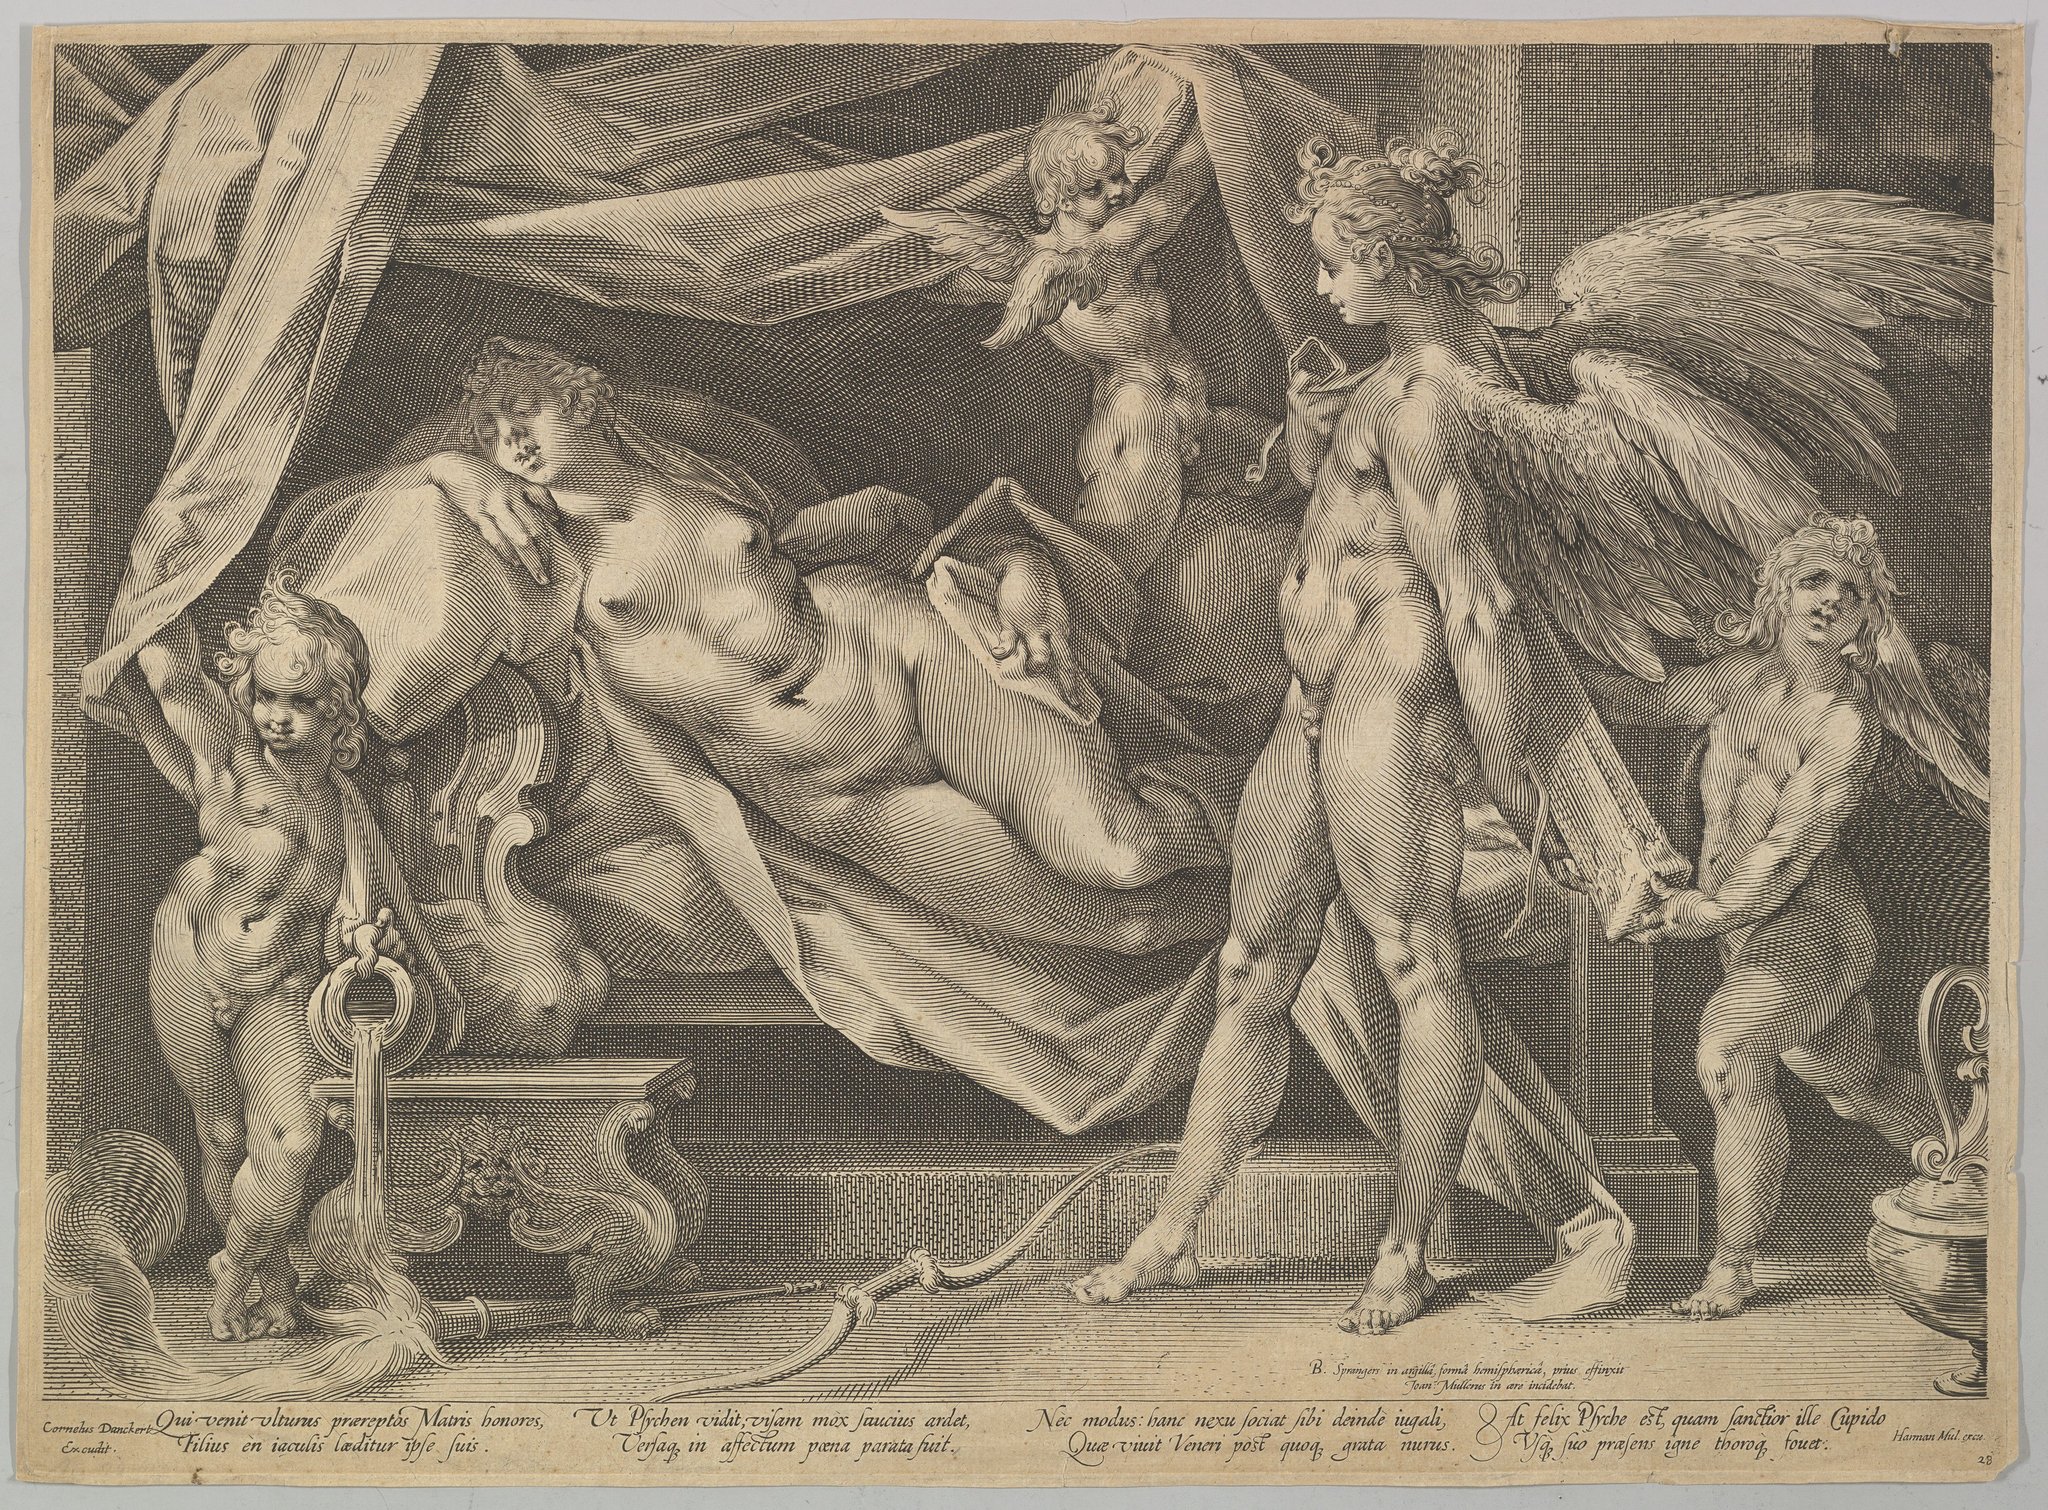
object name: print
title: Cupid and Psyche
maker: jan muller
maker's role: artist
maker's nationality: netherlandish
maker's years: 1571-1628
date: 1600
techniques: engraving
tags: cupid,psyche